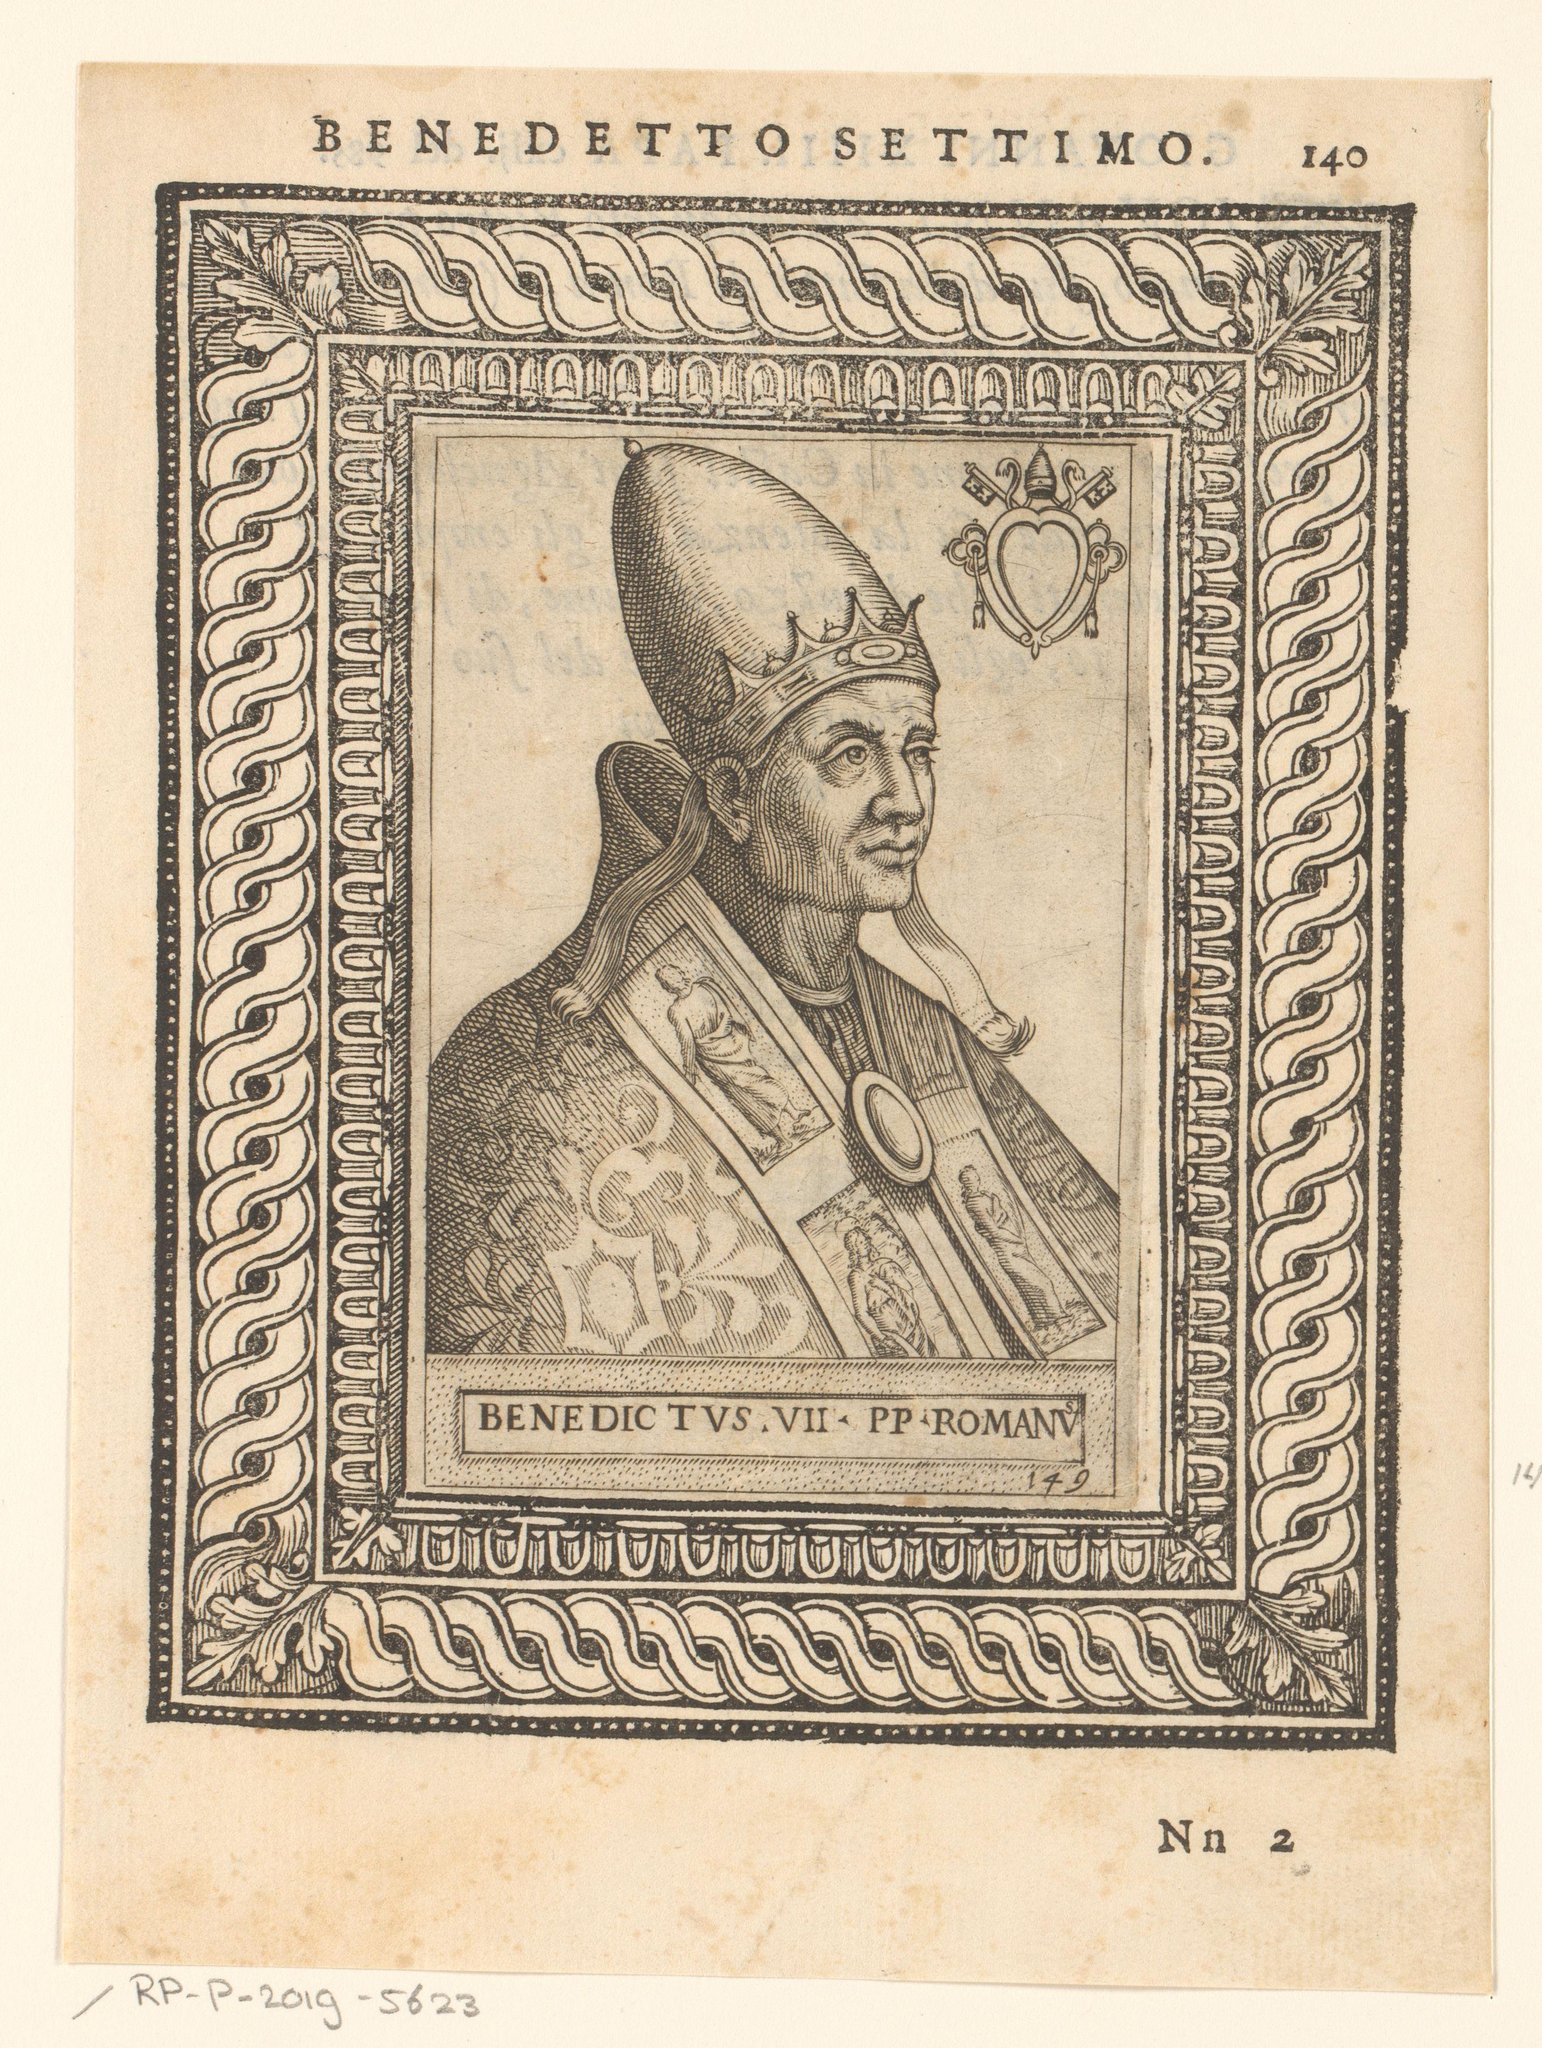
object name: print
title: Benedictus VII PP Romanus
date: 1587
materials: paper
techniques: engraving, letterpress printing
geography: rome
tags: historical persons, pope, armorial bearing, heraldry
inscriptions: collector's mark: Lugt 2228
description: Prent uit: Ciccarelli, Antonio. Le vite de Pontefici di Antonio Ciccarelli (...). Rome: Domenico Basa, 1587. Prent voor het eerst verschenen in: Cavalieri, Giovanni Battista de'. Pontificum romanorum effigies (...). Rome: Domenico Basa en Francesco Zanetti, 1580. Prent ook gebruikt in latere publicaties.